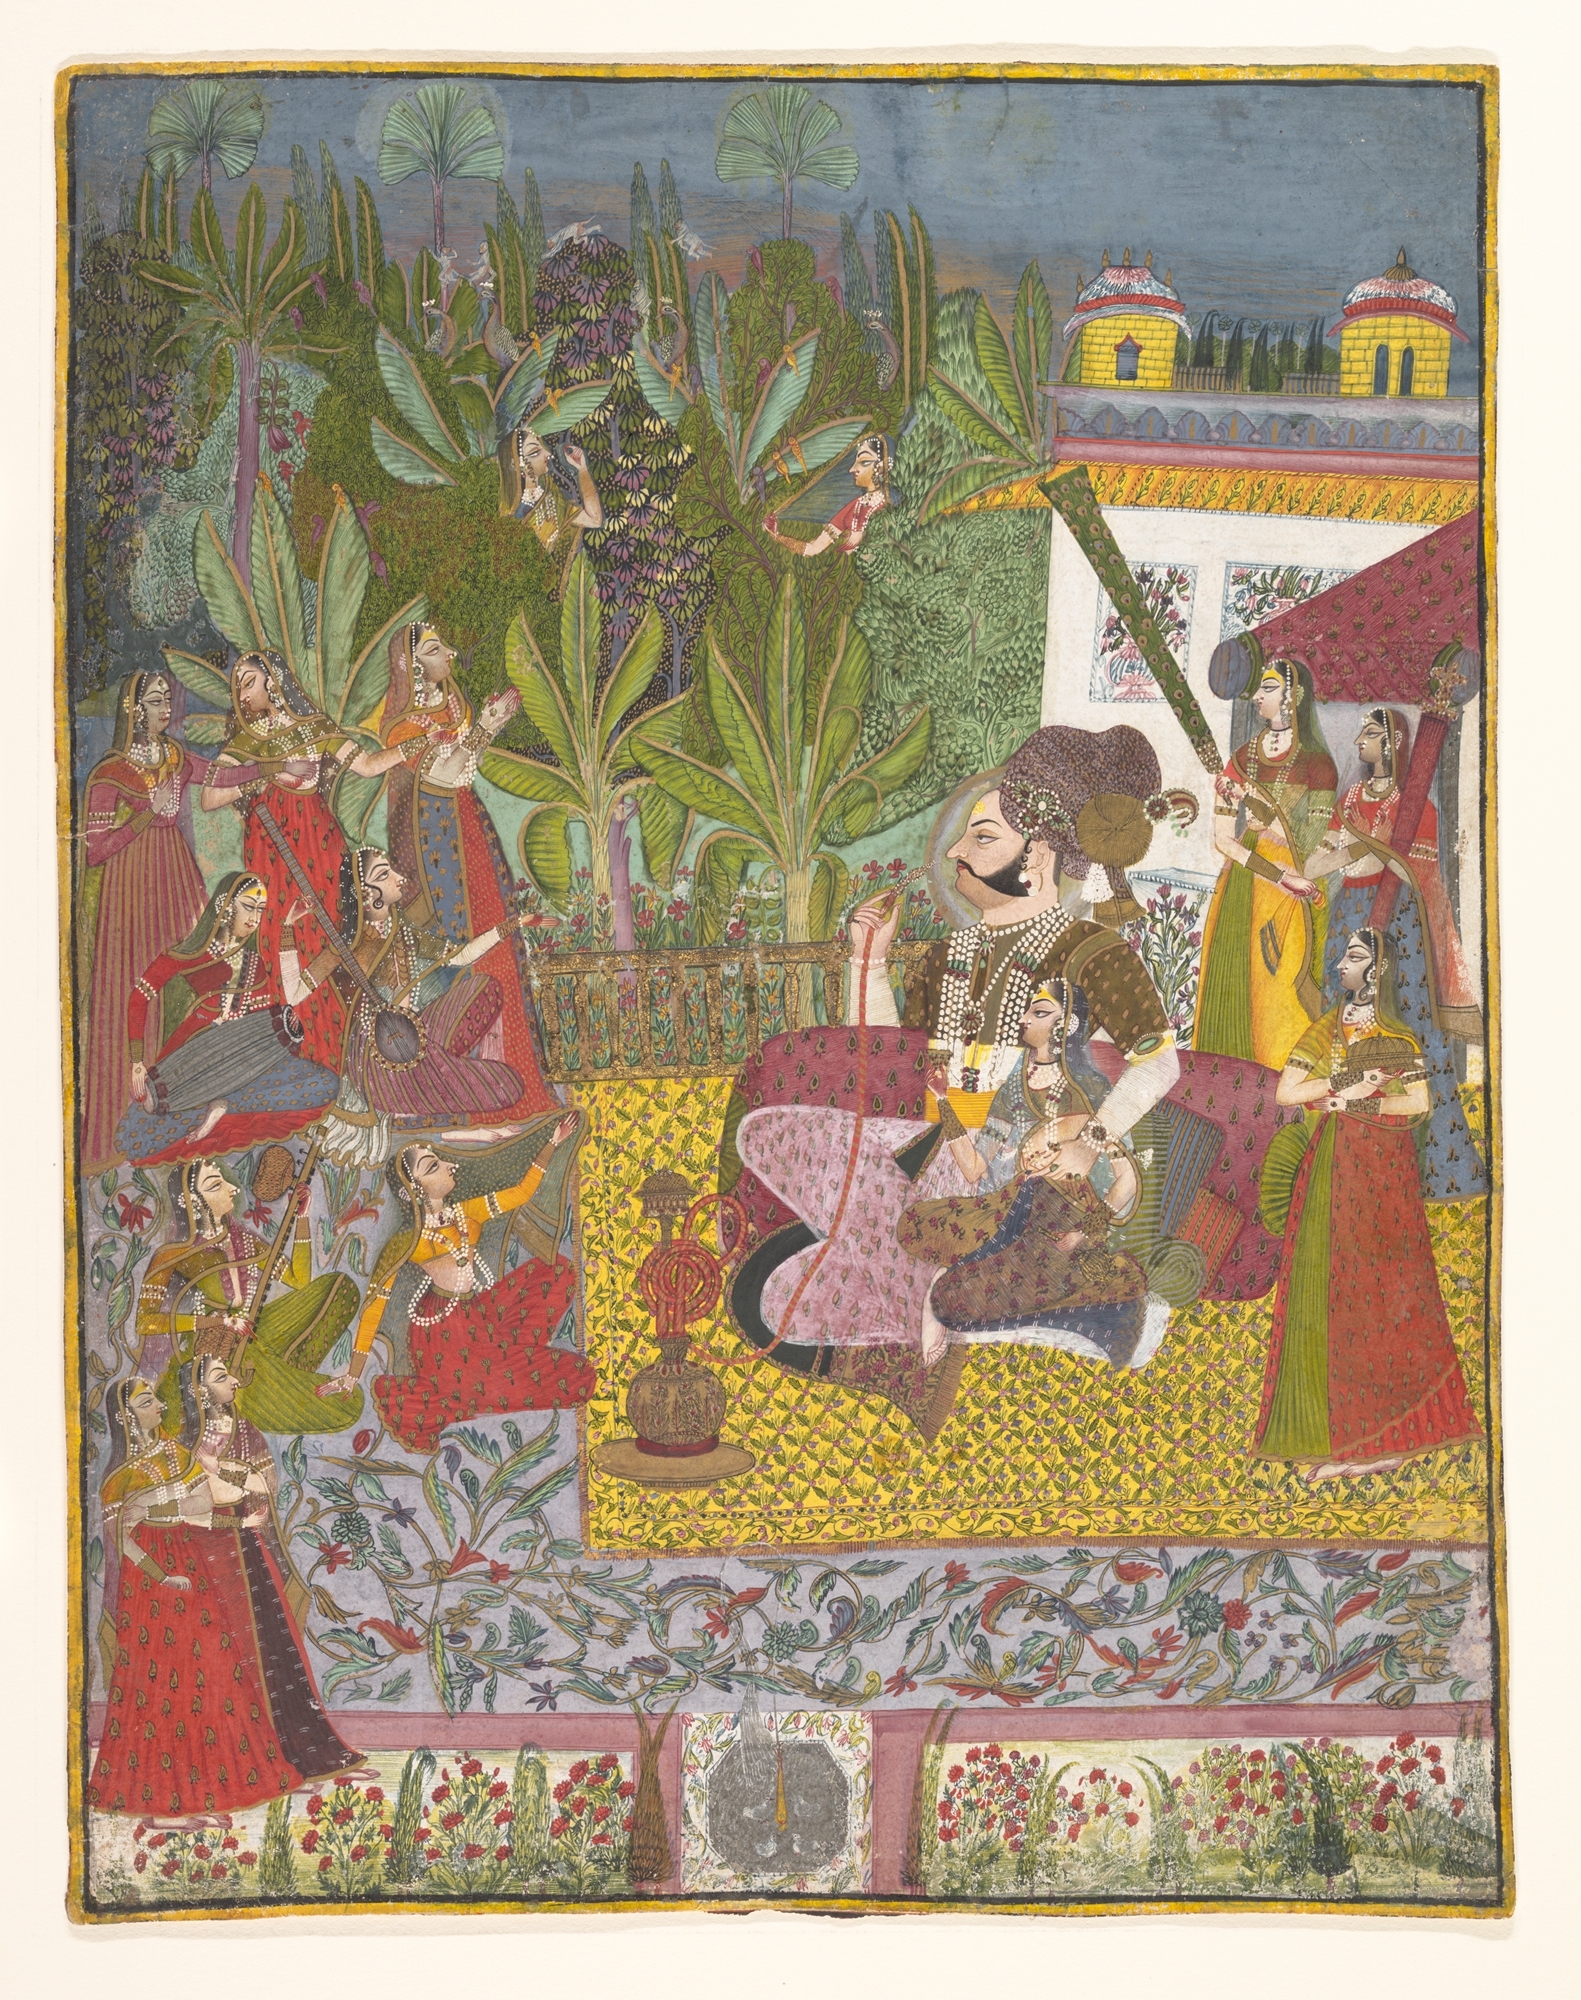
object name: painting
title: Maharaja Bijay Singh in His Harem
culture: indian, rajasthan, jodhpur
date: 1770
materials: gold, ink, paper, watercolor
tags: musical instruments,men,women,smoking,musicians,hookah